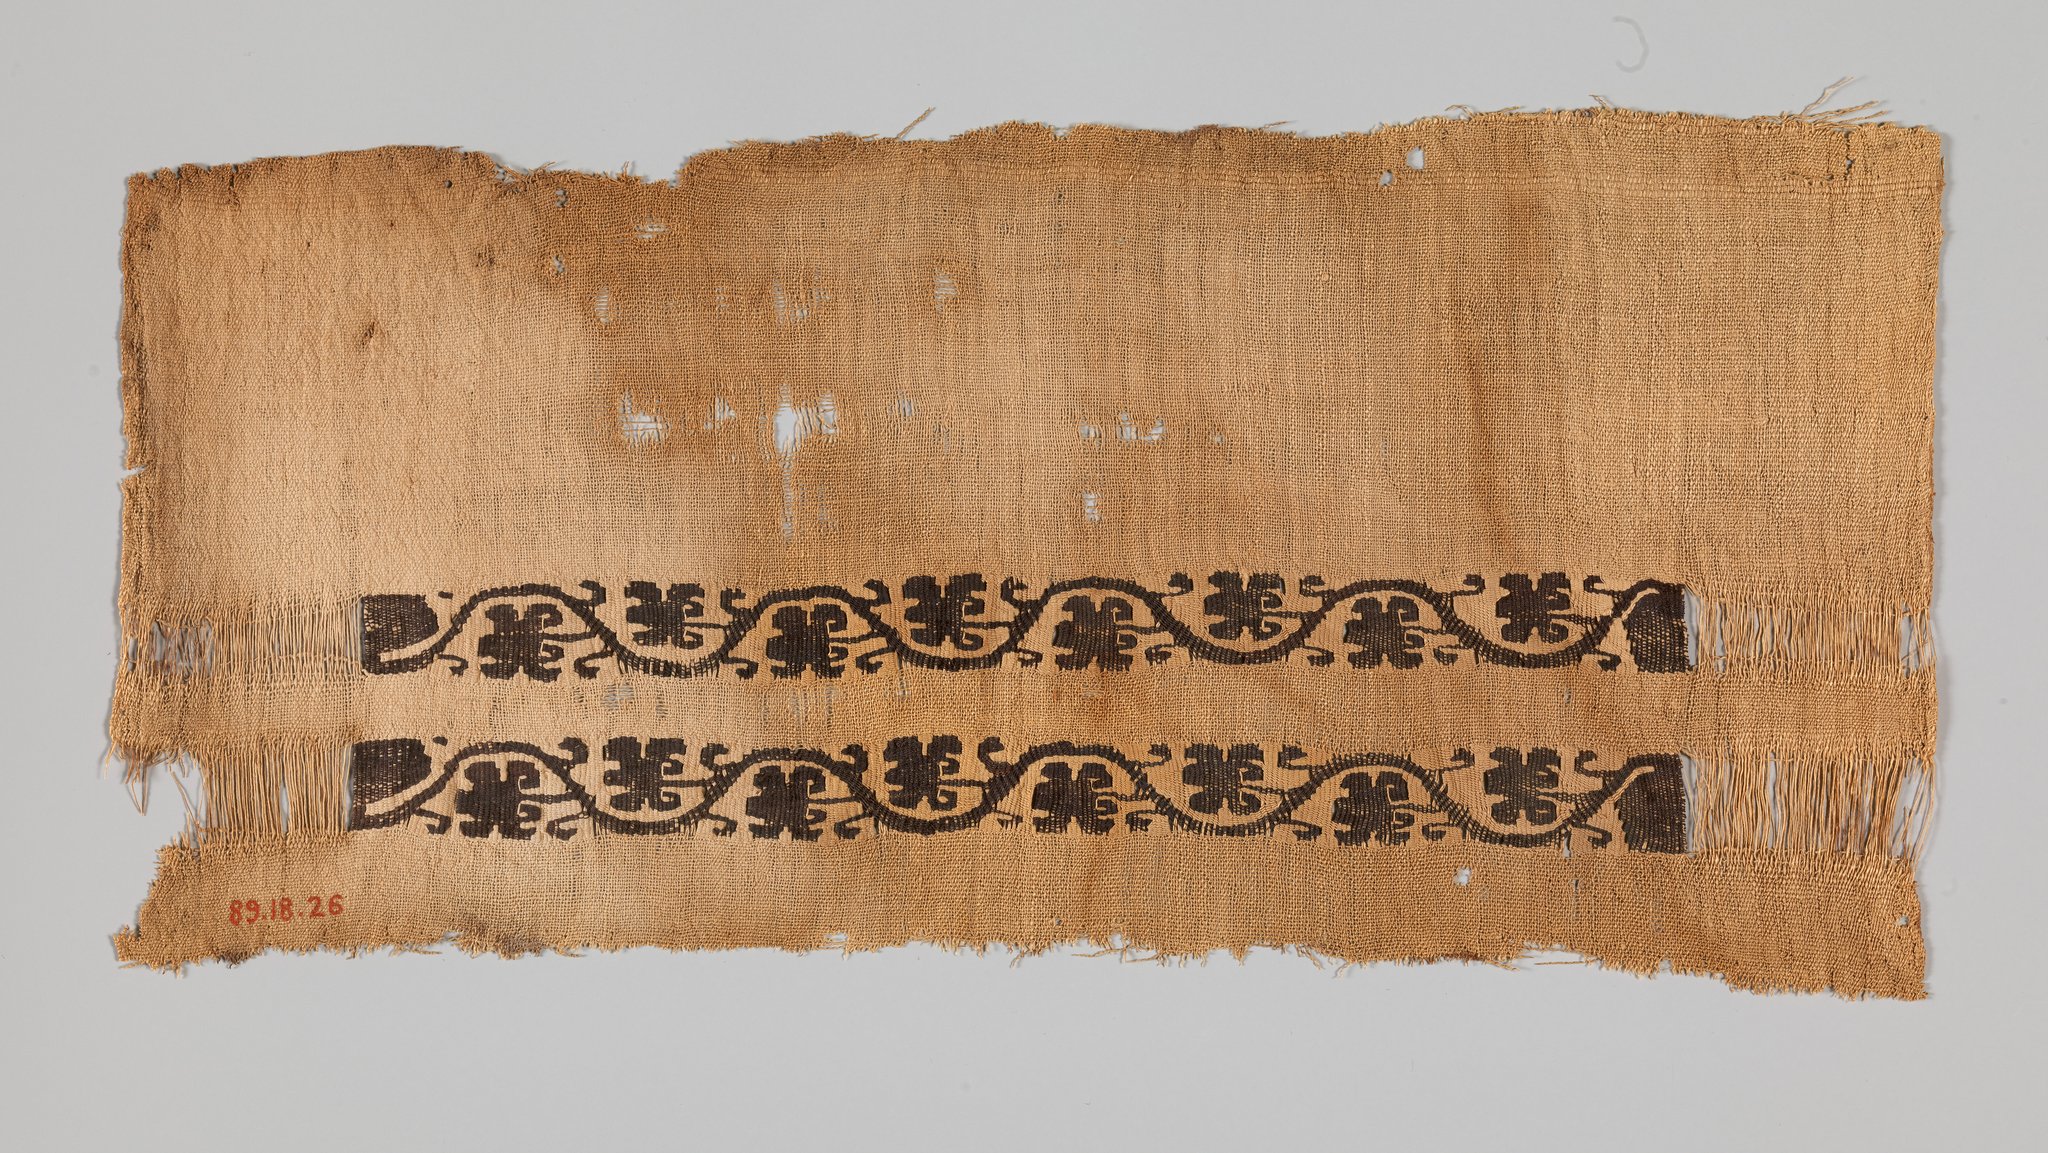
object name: textile fragment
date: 201-400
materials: linen, wool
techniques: weave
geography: egypt